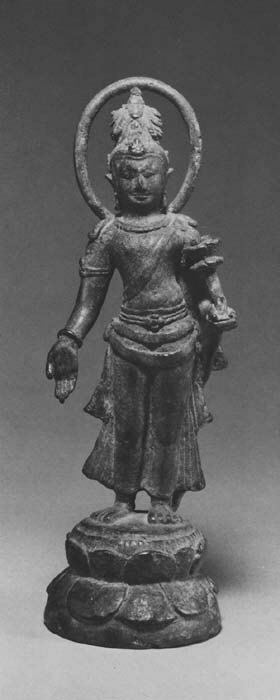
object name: figure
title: Standing Padmapani Lokeshvara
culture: indonesian, javanese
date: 834-866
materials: bronze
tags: buddhism,bodhisattvas